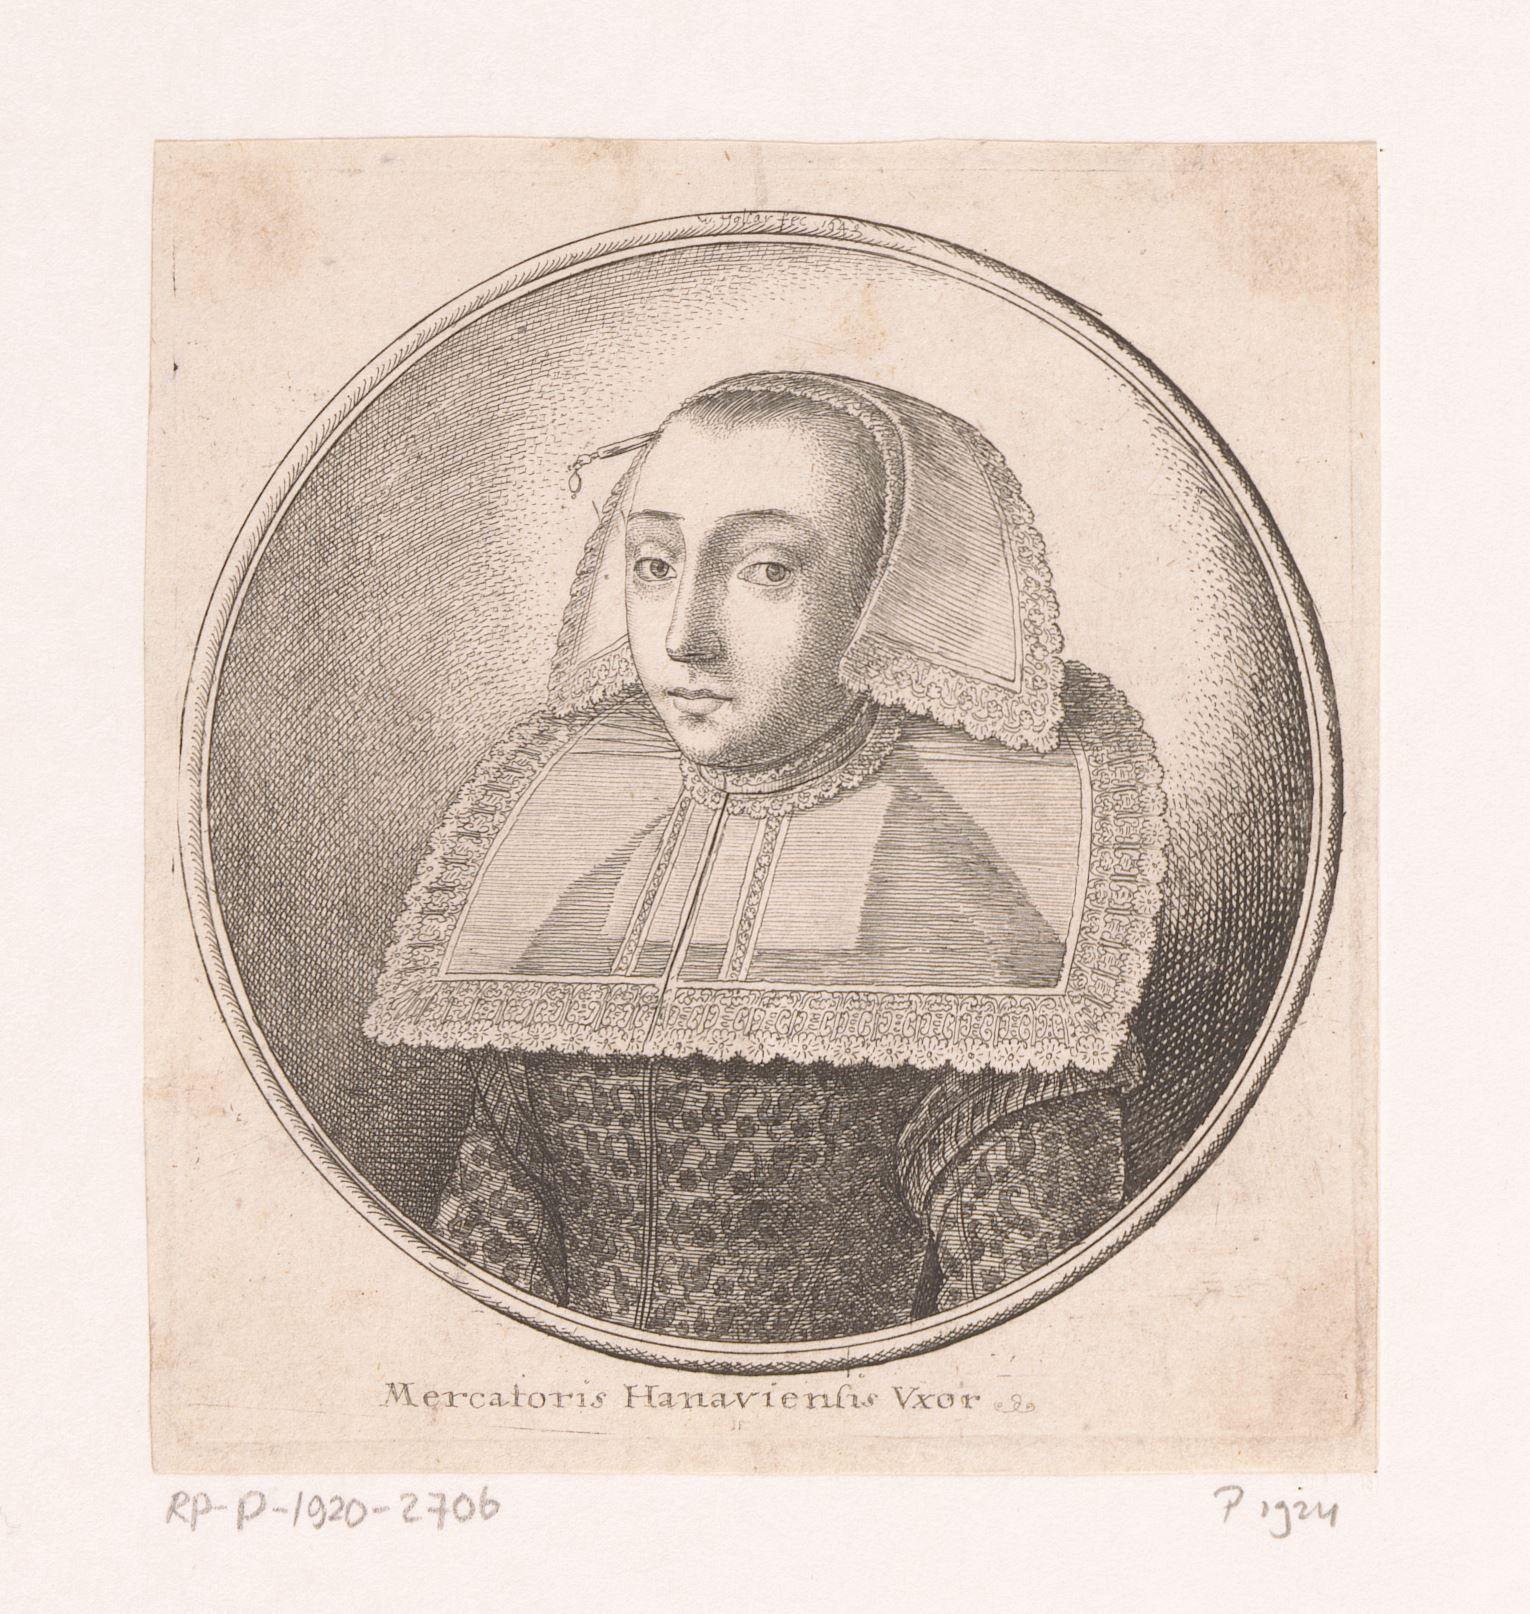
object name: costume print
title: Vrouwenbusten in ronde lijsten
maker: wenceslaus hollar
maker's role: draughtsman, print maker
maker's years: 1607-1677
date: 1642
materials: paper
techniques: etching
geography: london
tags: head-gear and clothing for the upper part of the body, ornament ~ medallion, styles of hairdress - aa - ~ women, fashion plates, lace, neck-gear: collar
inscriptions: collector's mark: Lugt 2228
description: Deze prent maakt deel uit van een serie bestaande uit 37 kostuumprenten.